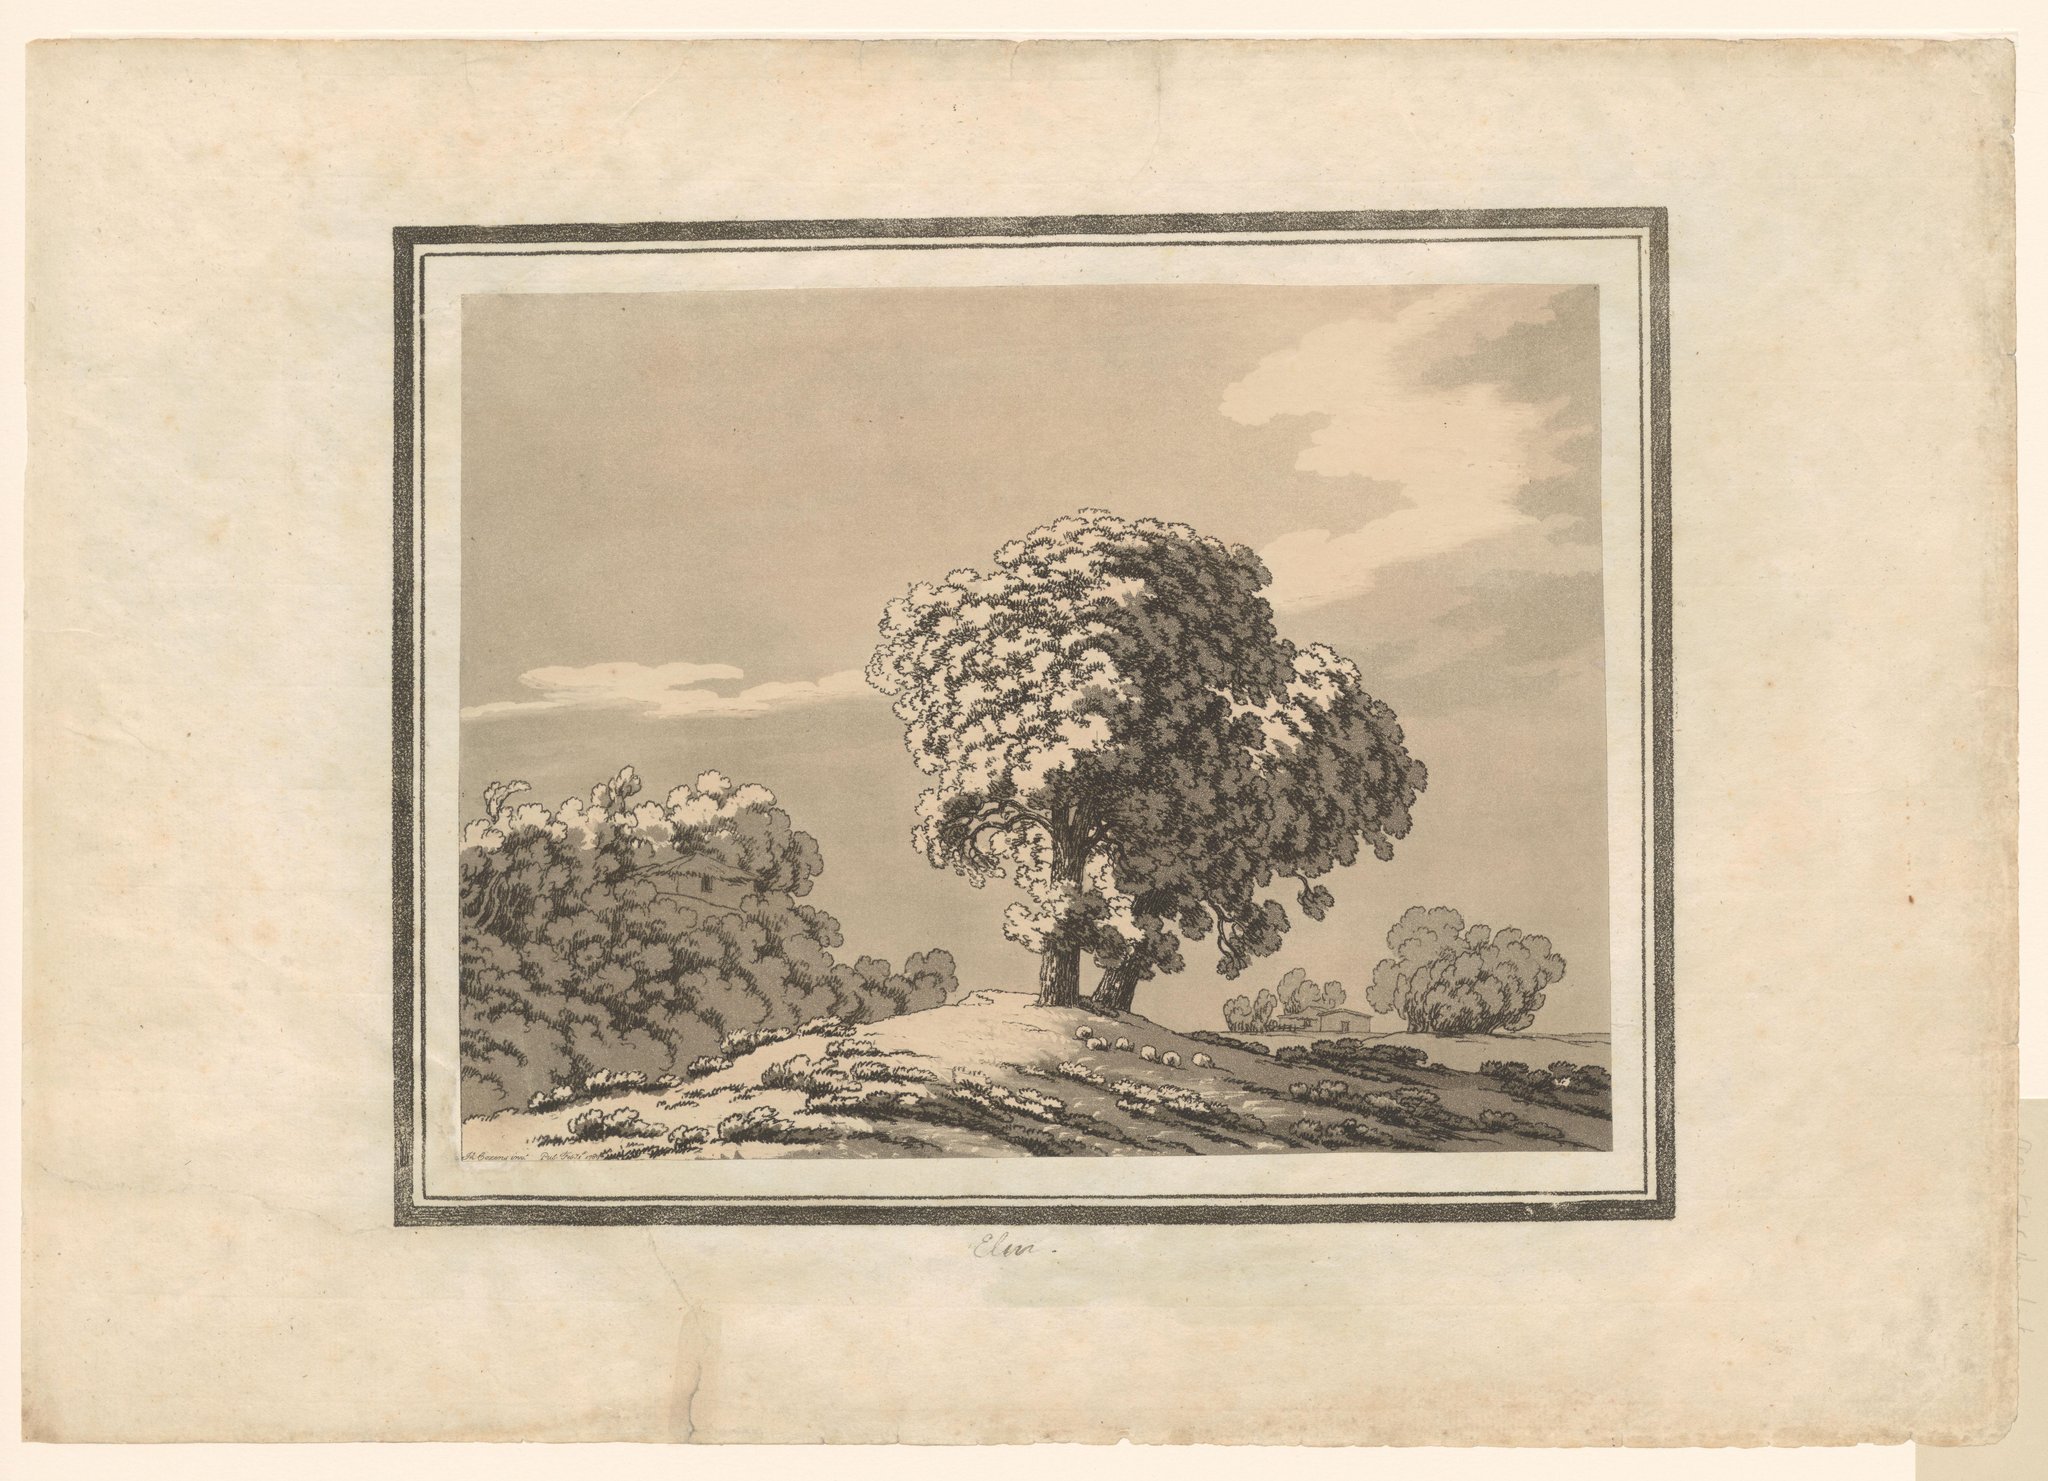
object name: print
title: Elm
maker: john robert cozens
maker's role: draughtsman, print maker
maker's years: 1752-1797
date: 1789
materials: paper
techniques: aquatint, soft ground etching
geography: london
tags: trees: elm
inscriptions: title: ‘Elm.’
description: Cozens depicts the sunlight in this landscape with meticulous care, using differences in tone to suggest a sense of depth: sharp contrasts in the foreground, where the darkest tints appear, and increasingly light tints further back. Left, sunlight rakes the tops of the trees. Either the sun is just rising, or setting.